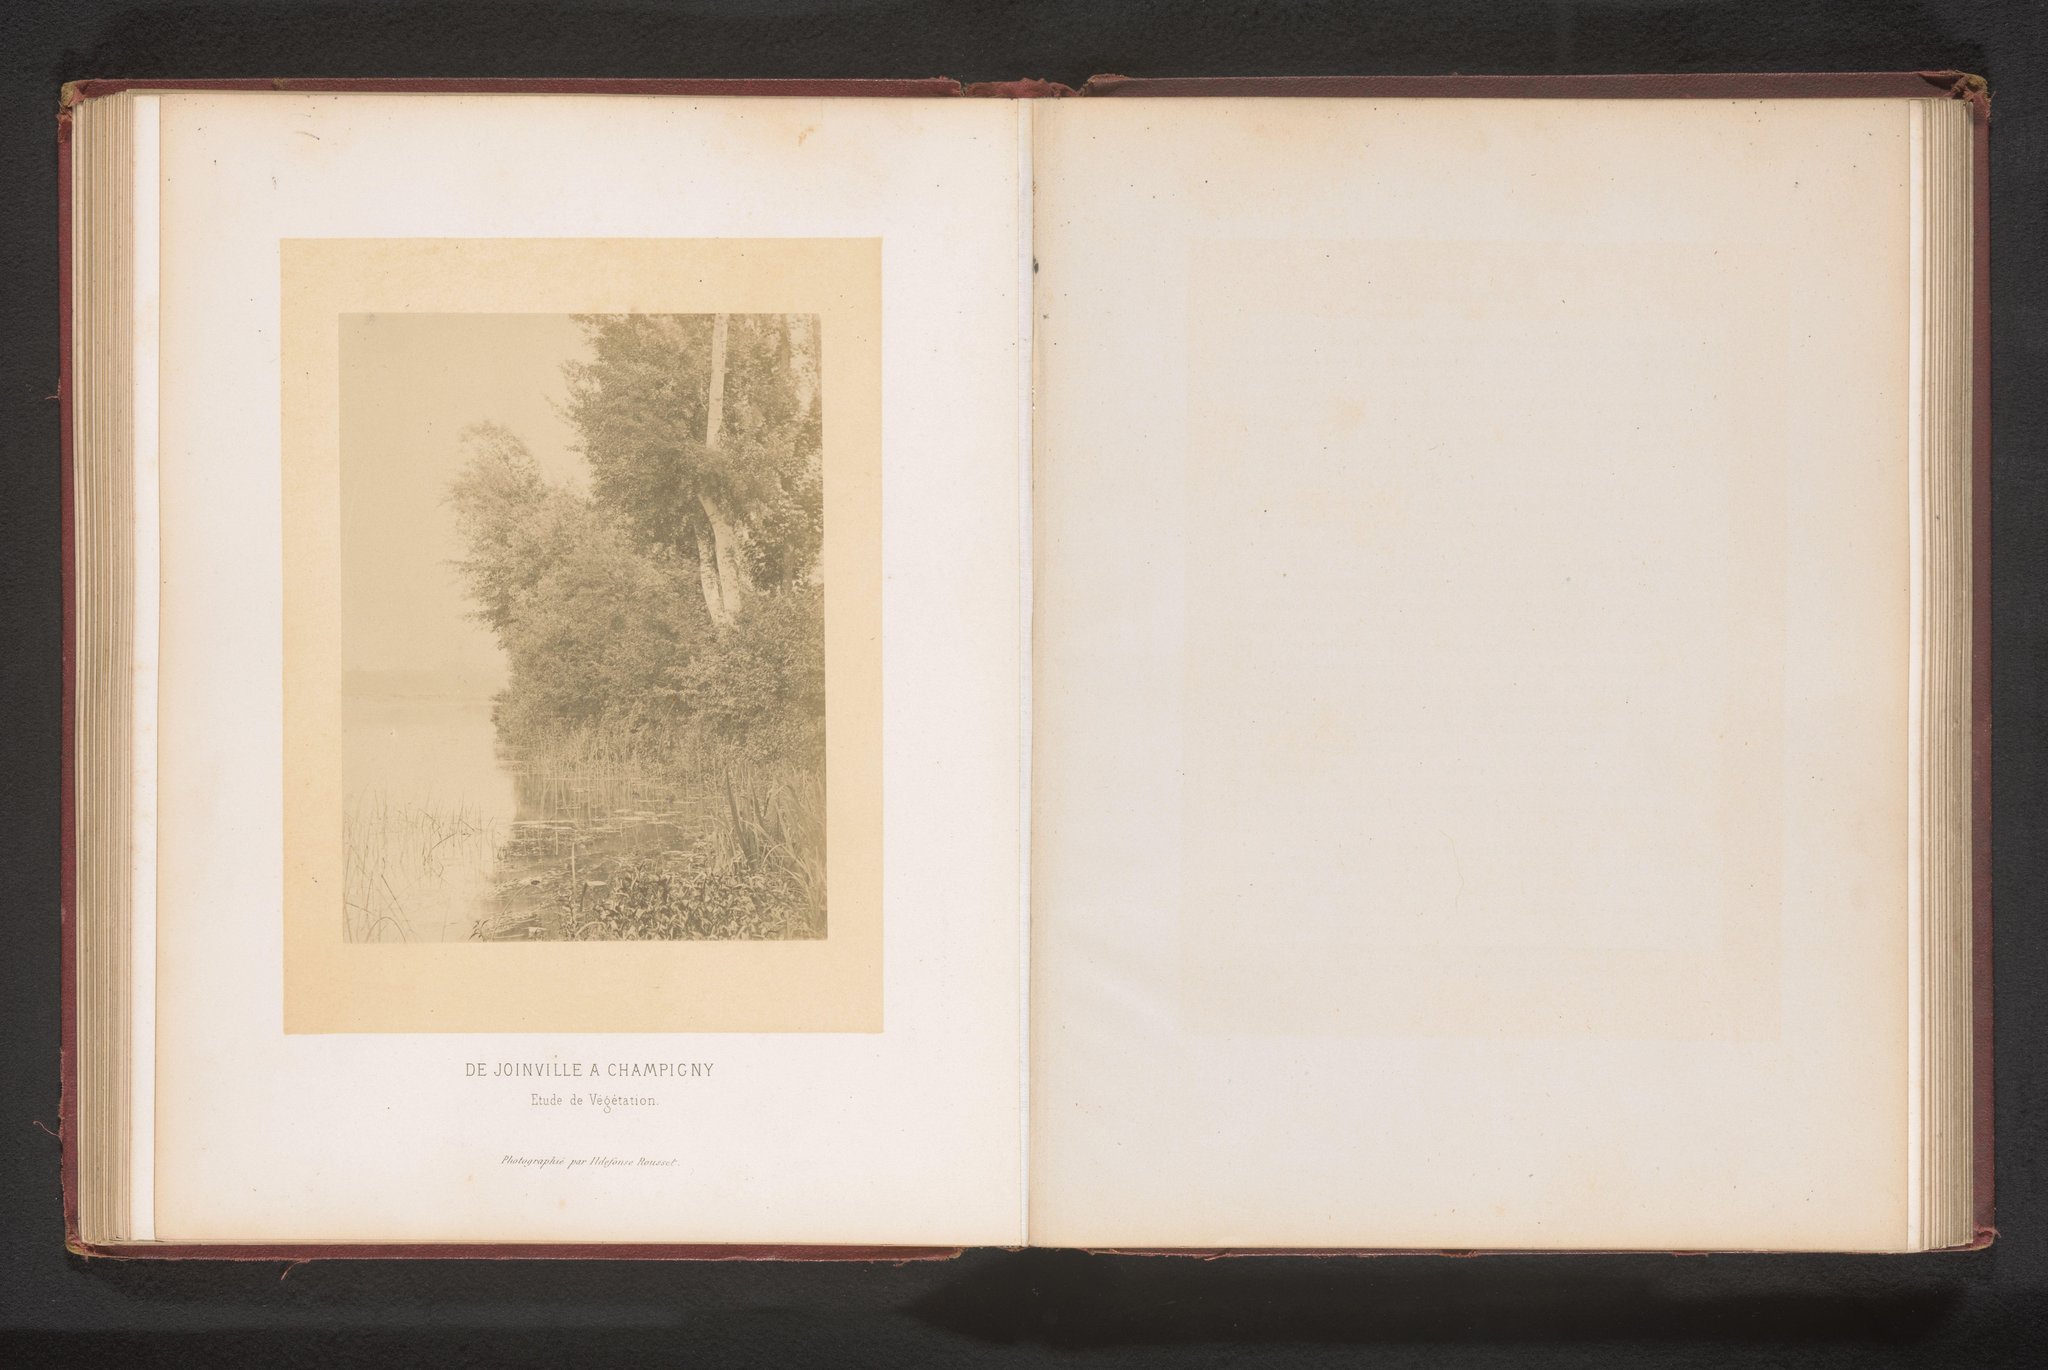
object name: photograph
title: Begroeiing langs de Marne nabij Champigny-sur-Marne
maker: ildefonse rousset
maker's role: fotograaf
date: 1860-1865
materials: photographic support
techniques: albumen print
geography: ile-de-france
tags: river, shrubs